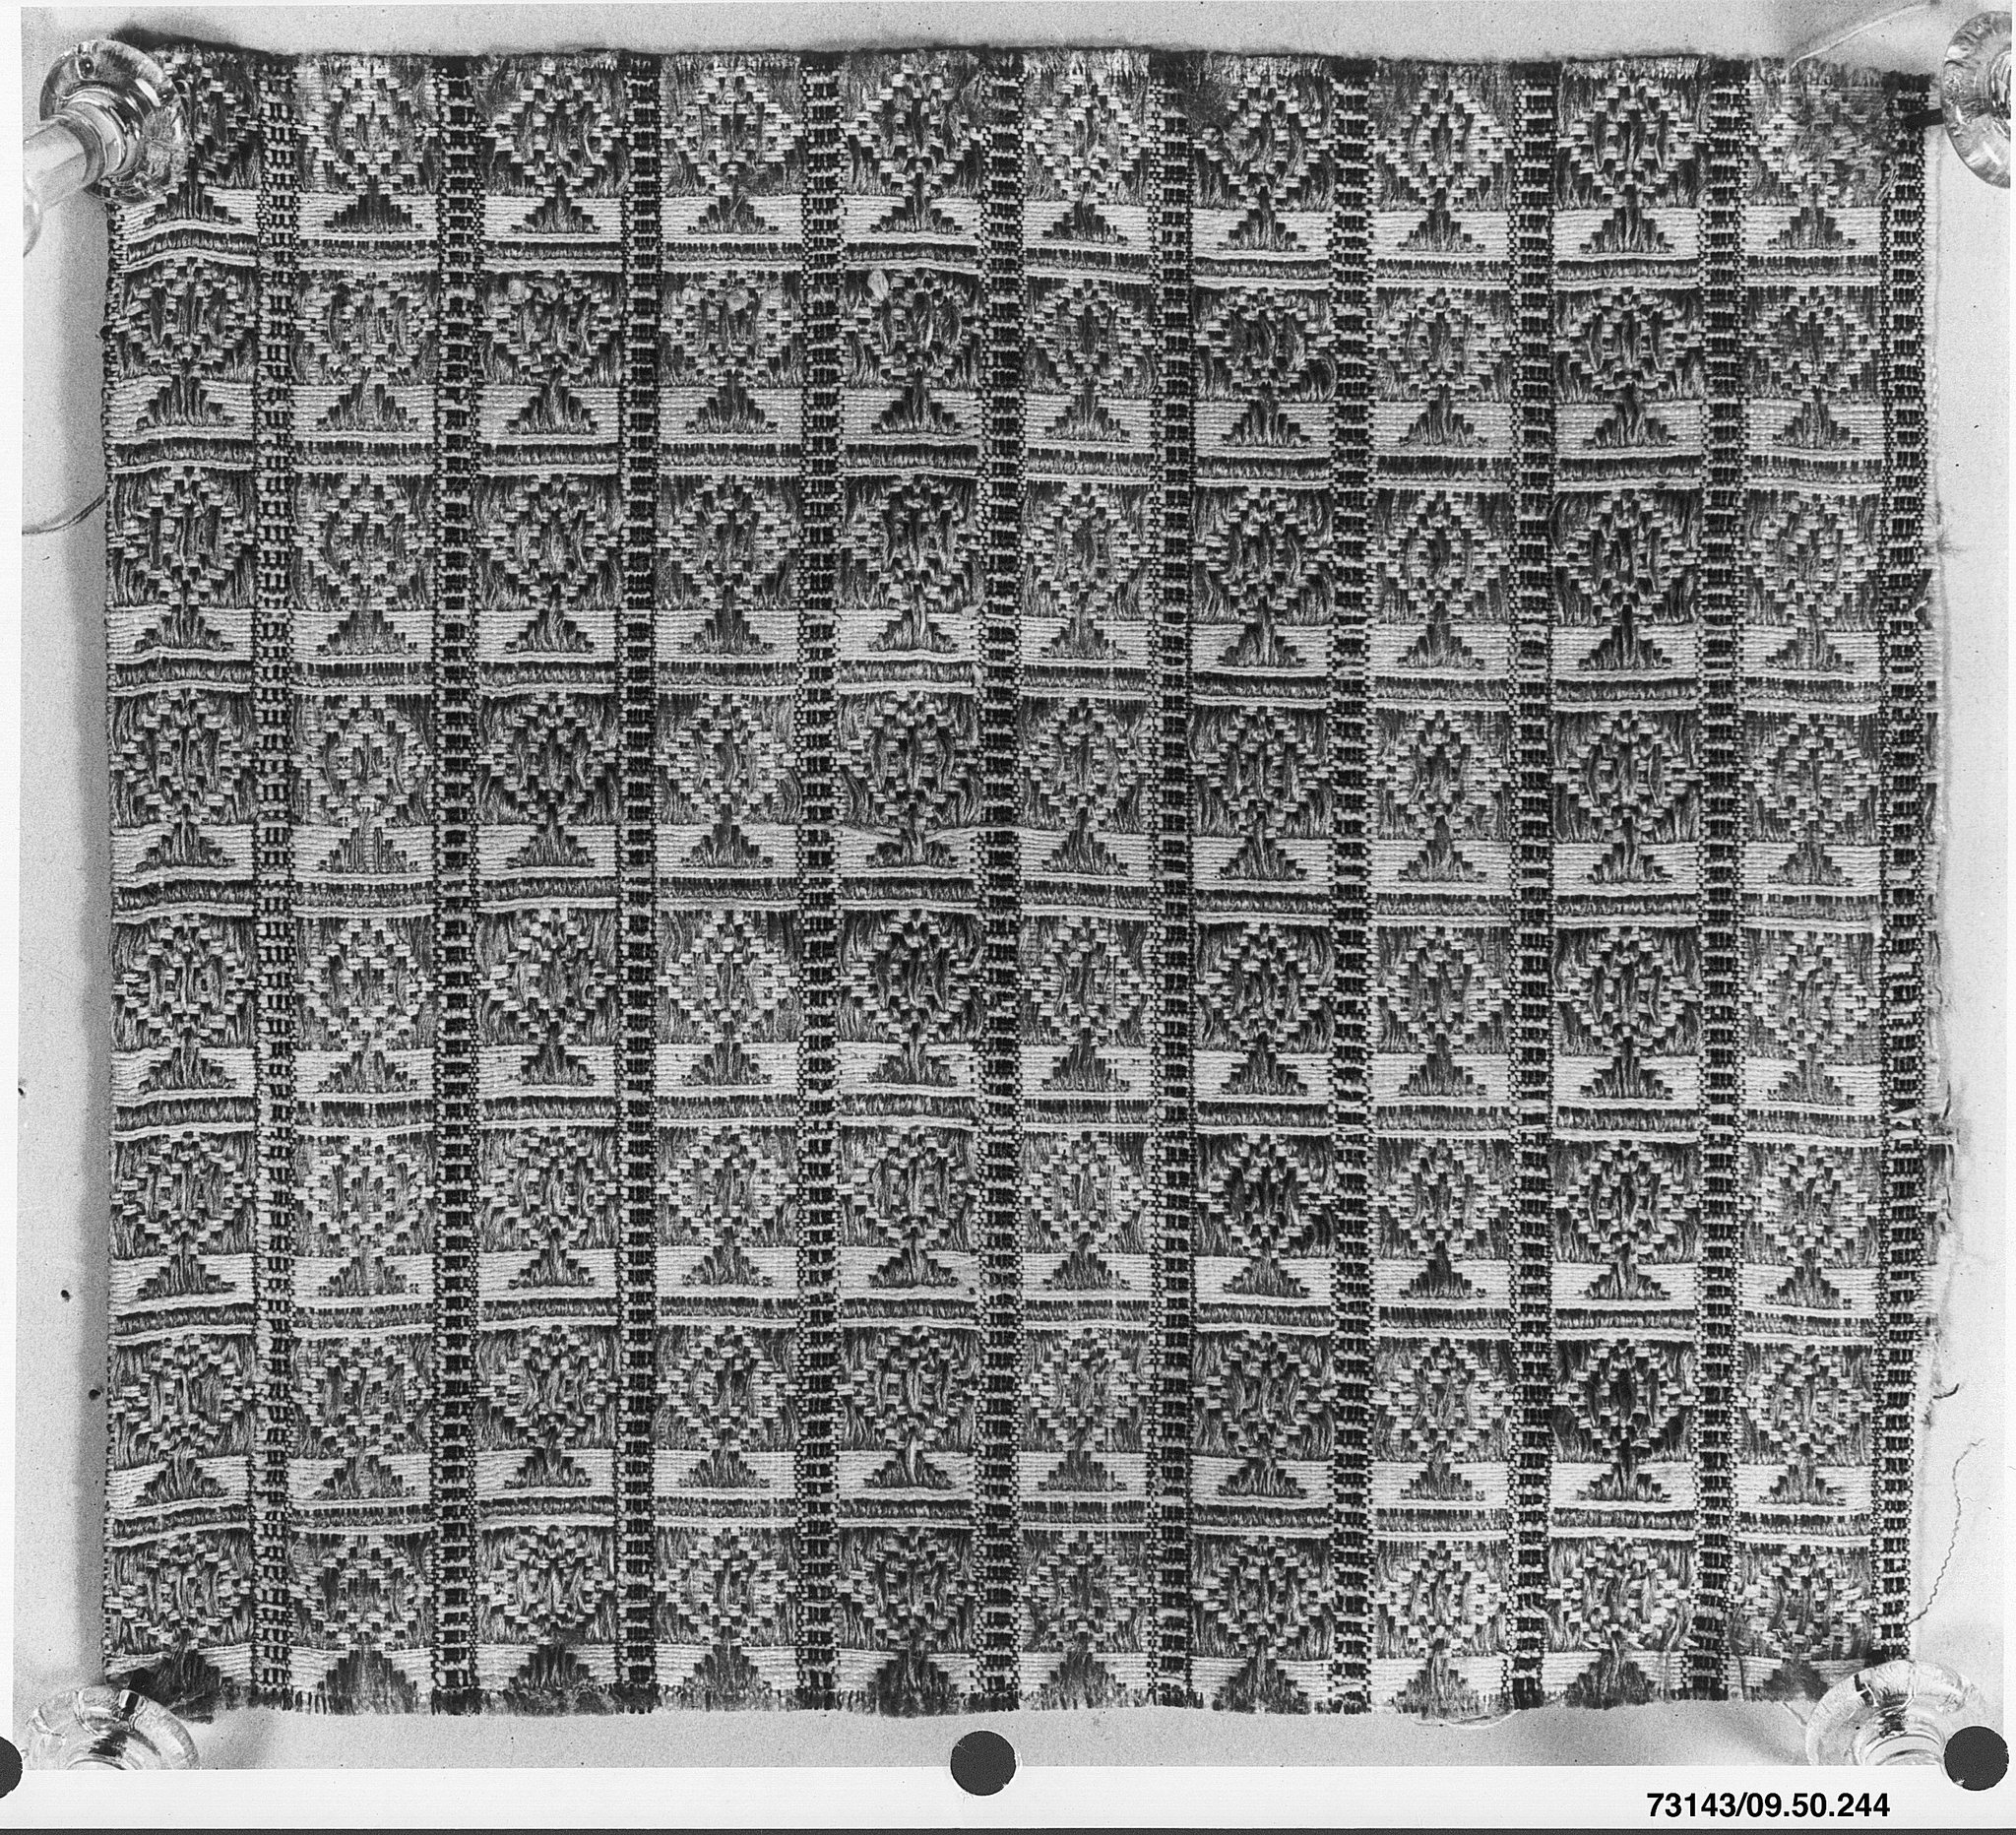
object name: fragment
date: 1801-1900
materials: cotton, silk